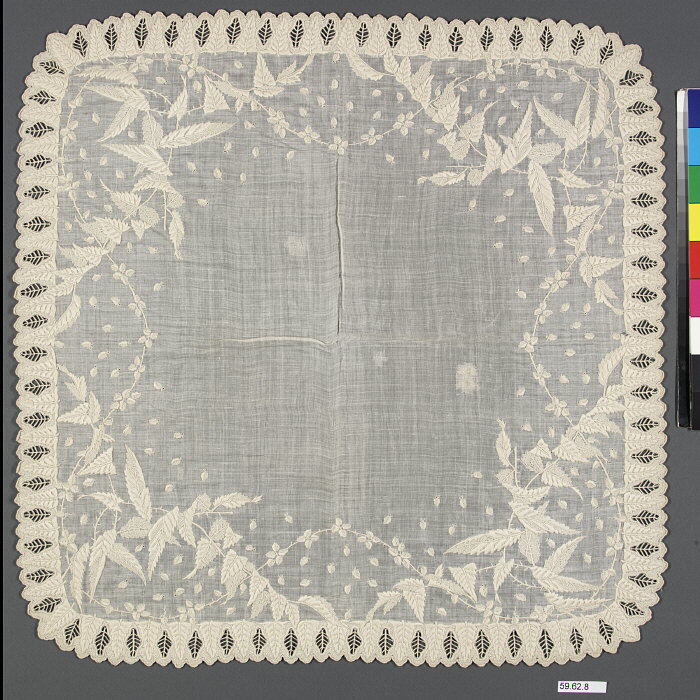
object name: handkerchief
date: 1801-1900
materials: linen